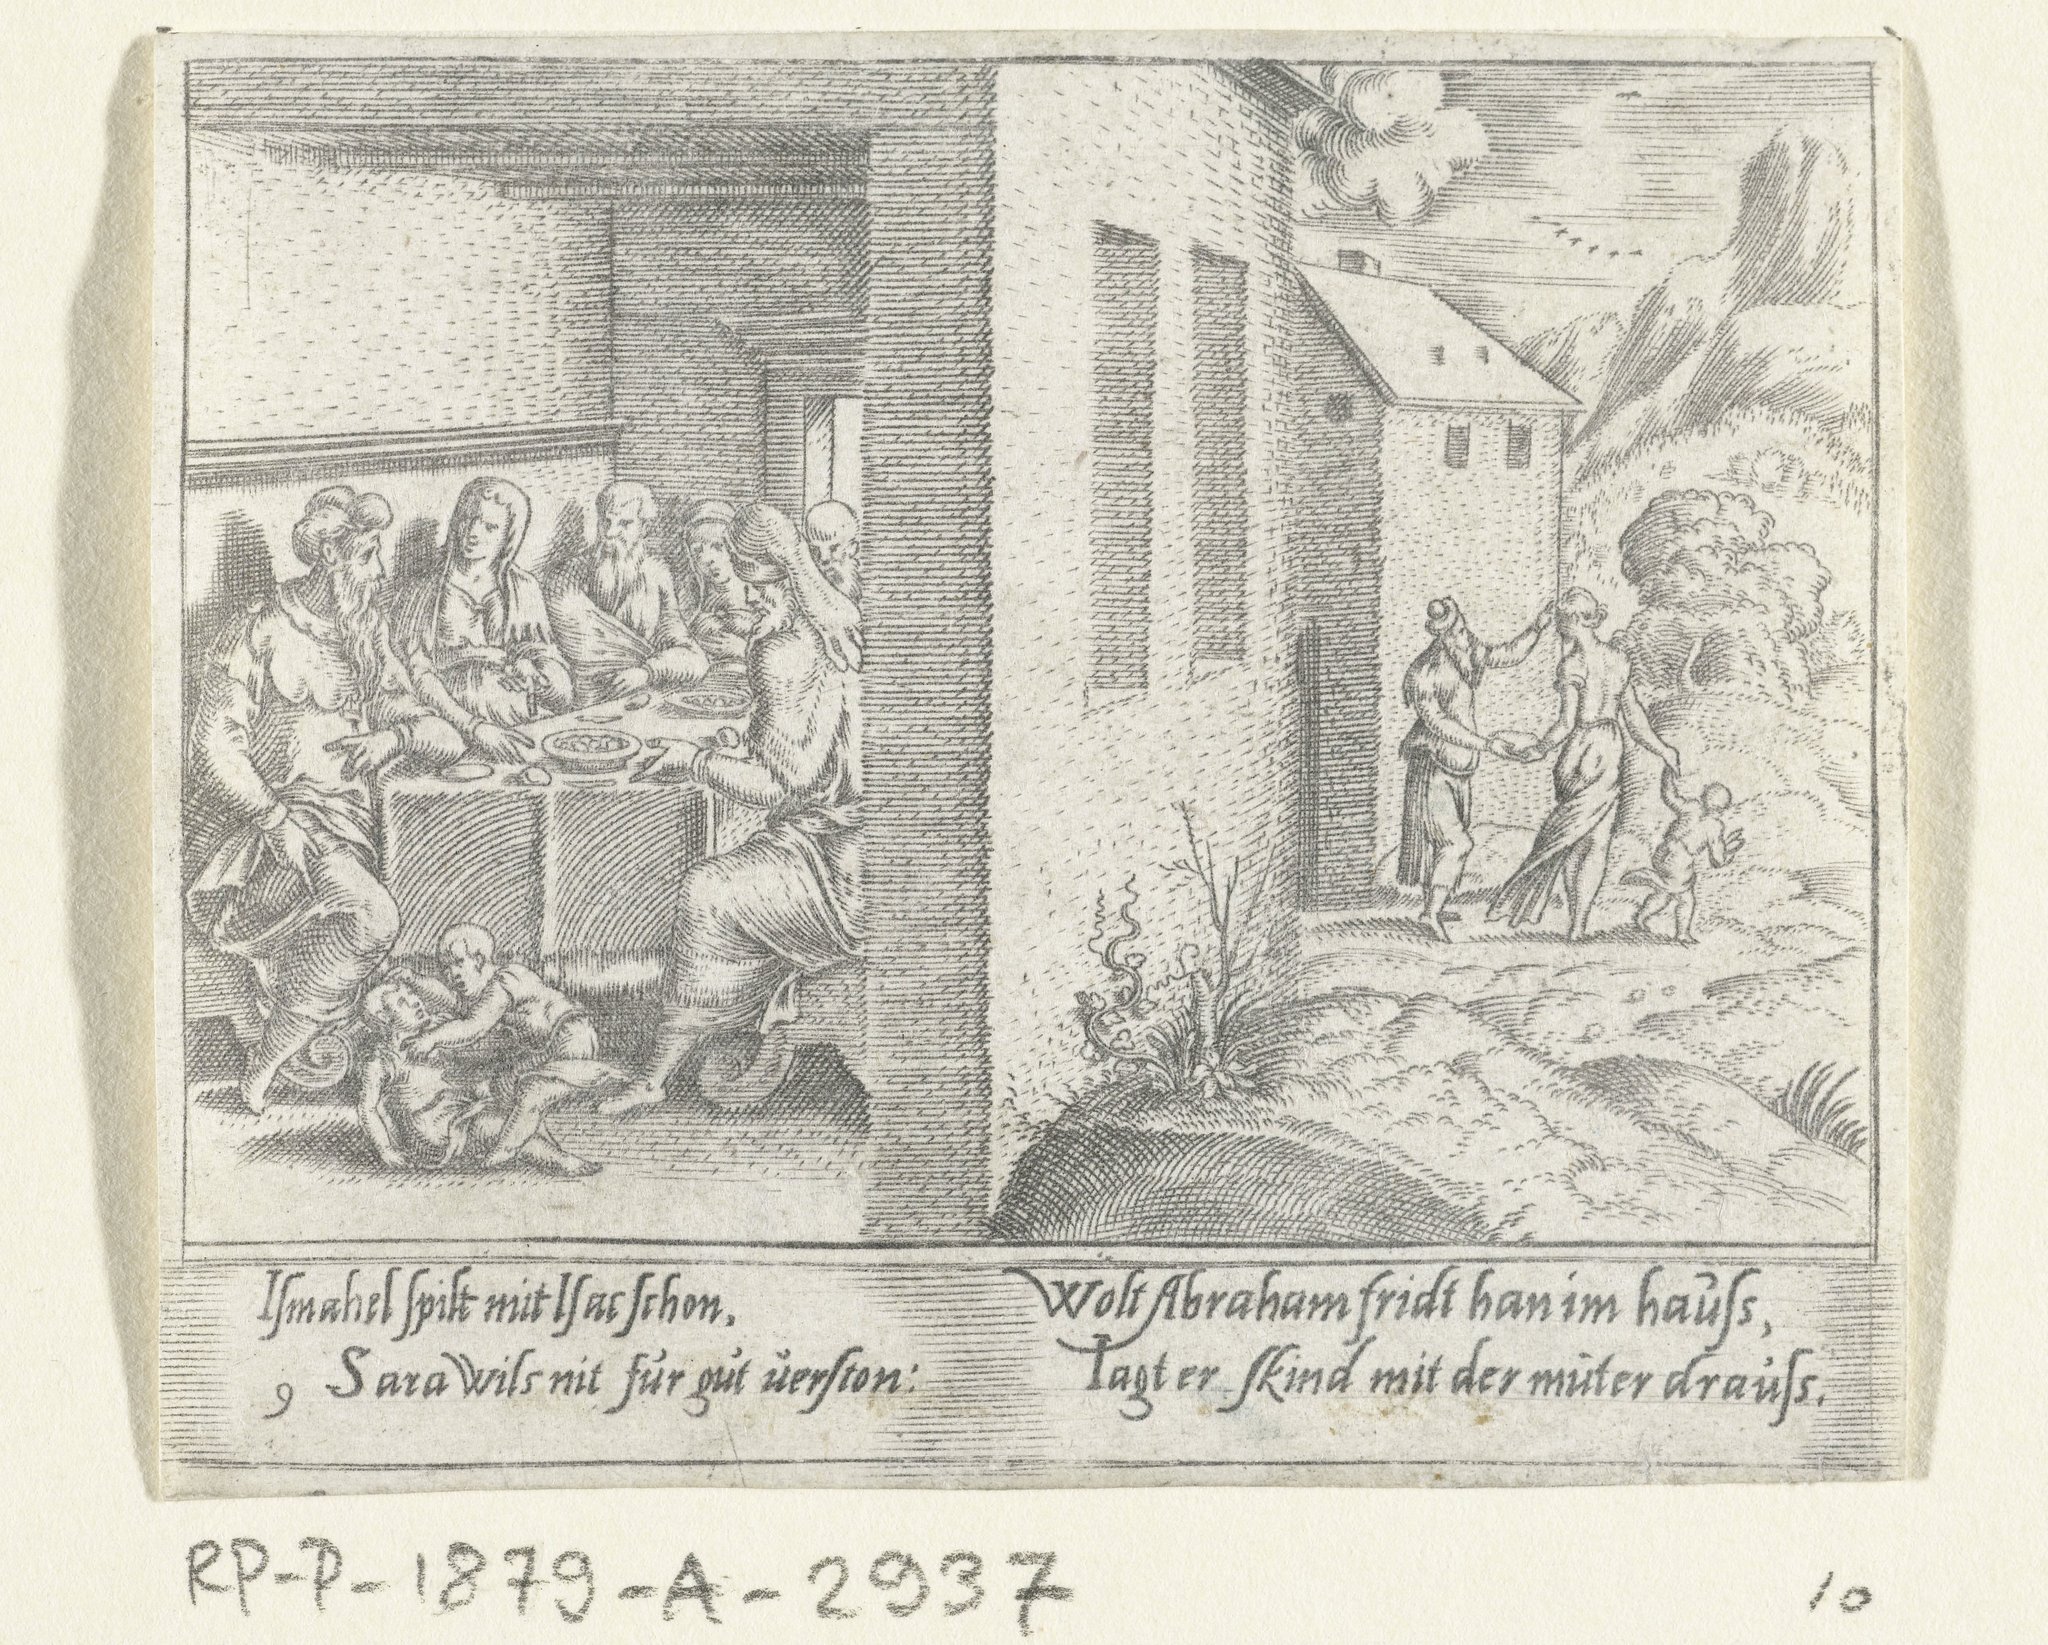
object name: print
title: Abraham verdrijft Hagar en Ismaël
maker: cornelis bos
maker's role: print maker, printer, publisher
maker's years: 1510-1566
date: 1555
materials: paper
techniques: engraving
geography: groningen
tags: the banishment of hagar and ishmael (genesis 21:9-21)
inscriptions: collector's mark: Lugt 2228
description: Ismaël bespot zijn broer Isaak. Ze vechten naast de tafel. Abraham beslist om Ismaël en Hagar weg te sturen en zo de ruzie op te lossen. Prent uit een serie van 12 prenten met het leven van Abraham. Alle prenten hebben vier regels Duitse verklarende tekst in de ondermarge.